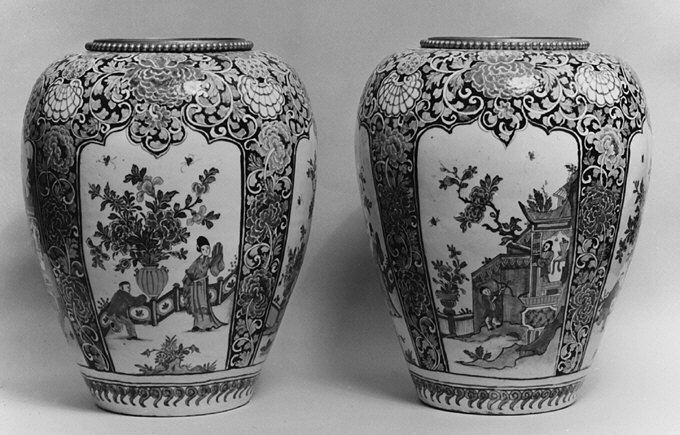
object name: vase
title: Pair of vases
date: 1701-1733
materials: earthenware, gilt bronze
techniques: glazing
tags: human figures,chinoiserie,flowers